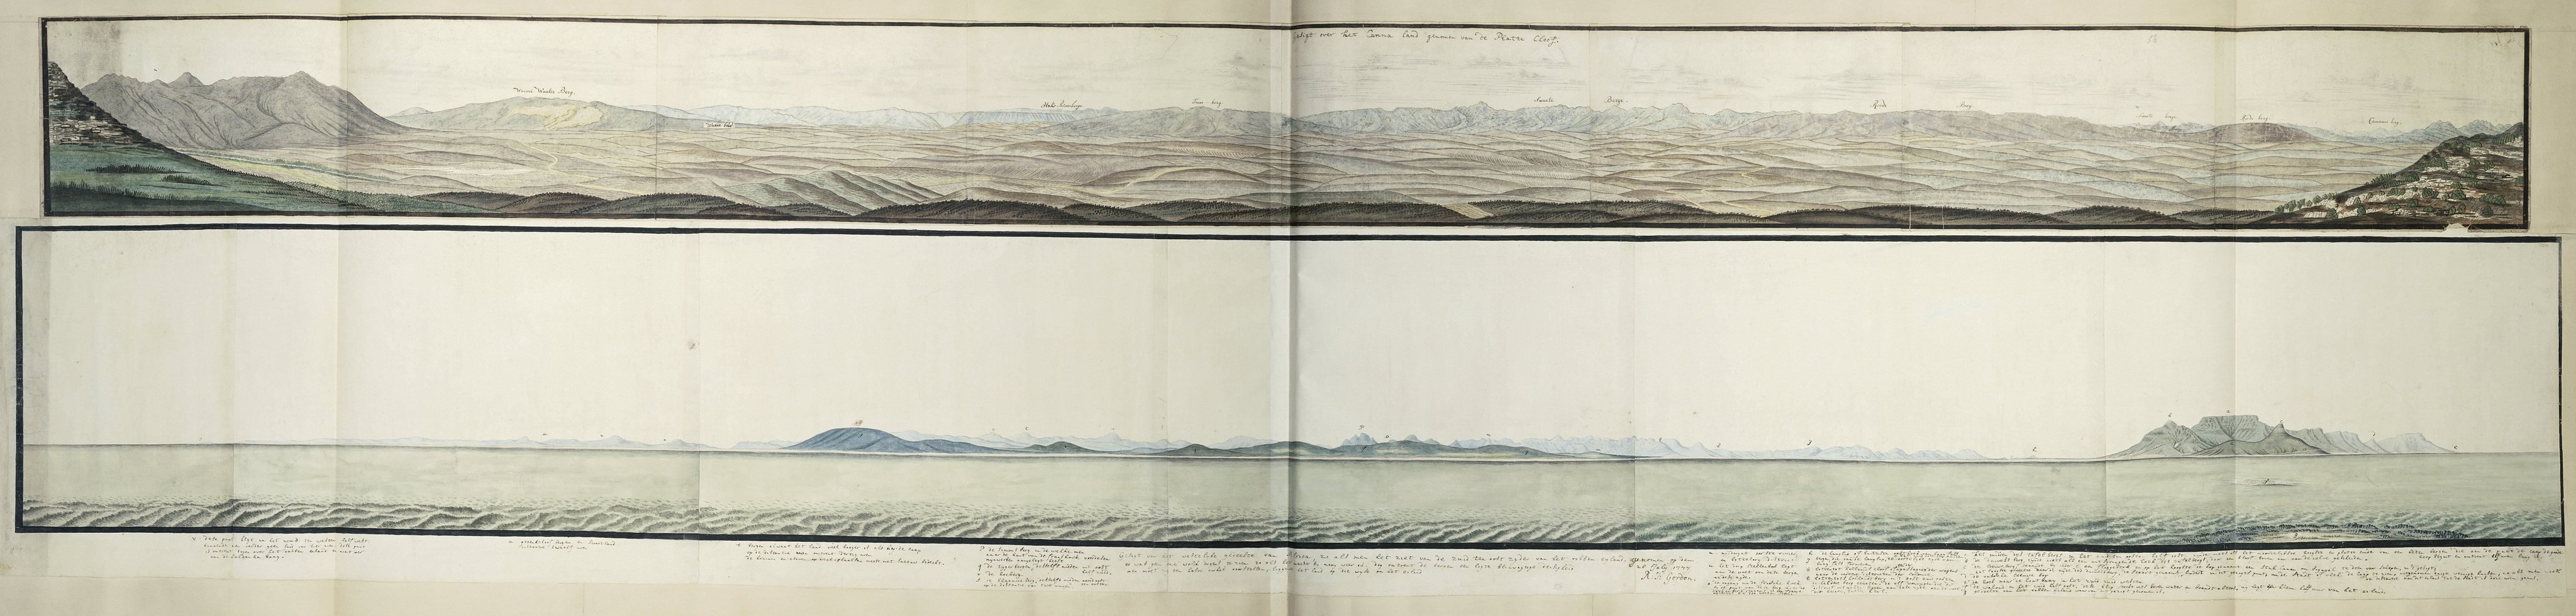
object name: drawing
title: Panorama of the west coast of the southern part of South Africa seen from Robben Island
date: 1777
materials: ink, paper, pencil, watercolor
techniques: brush, pen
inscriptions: signature and date: ‘...den 28 July 1777 R:J: Gordon/ ....’, annotation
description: Panorama van de westkust van het zuidelijkste deel van Zuid-Afrika, gezien vanaf Robbeneiland. Tekst ontsloten d.m.v. een gidskaart met delen A t/m D.